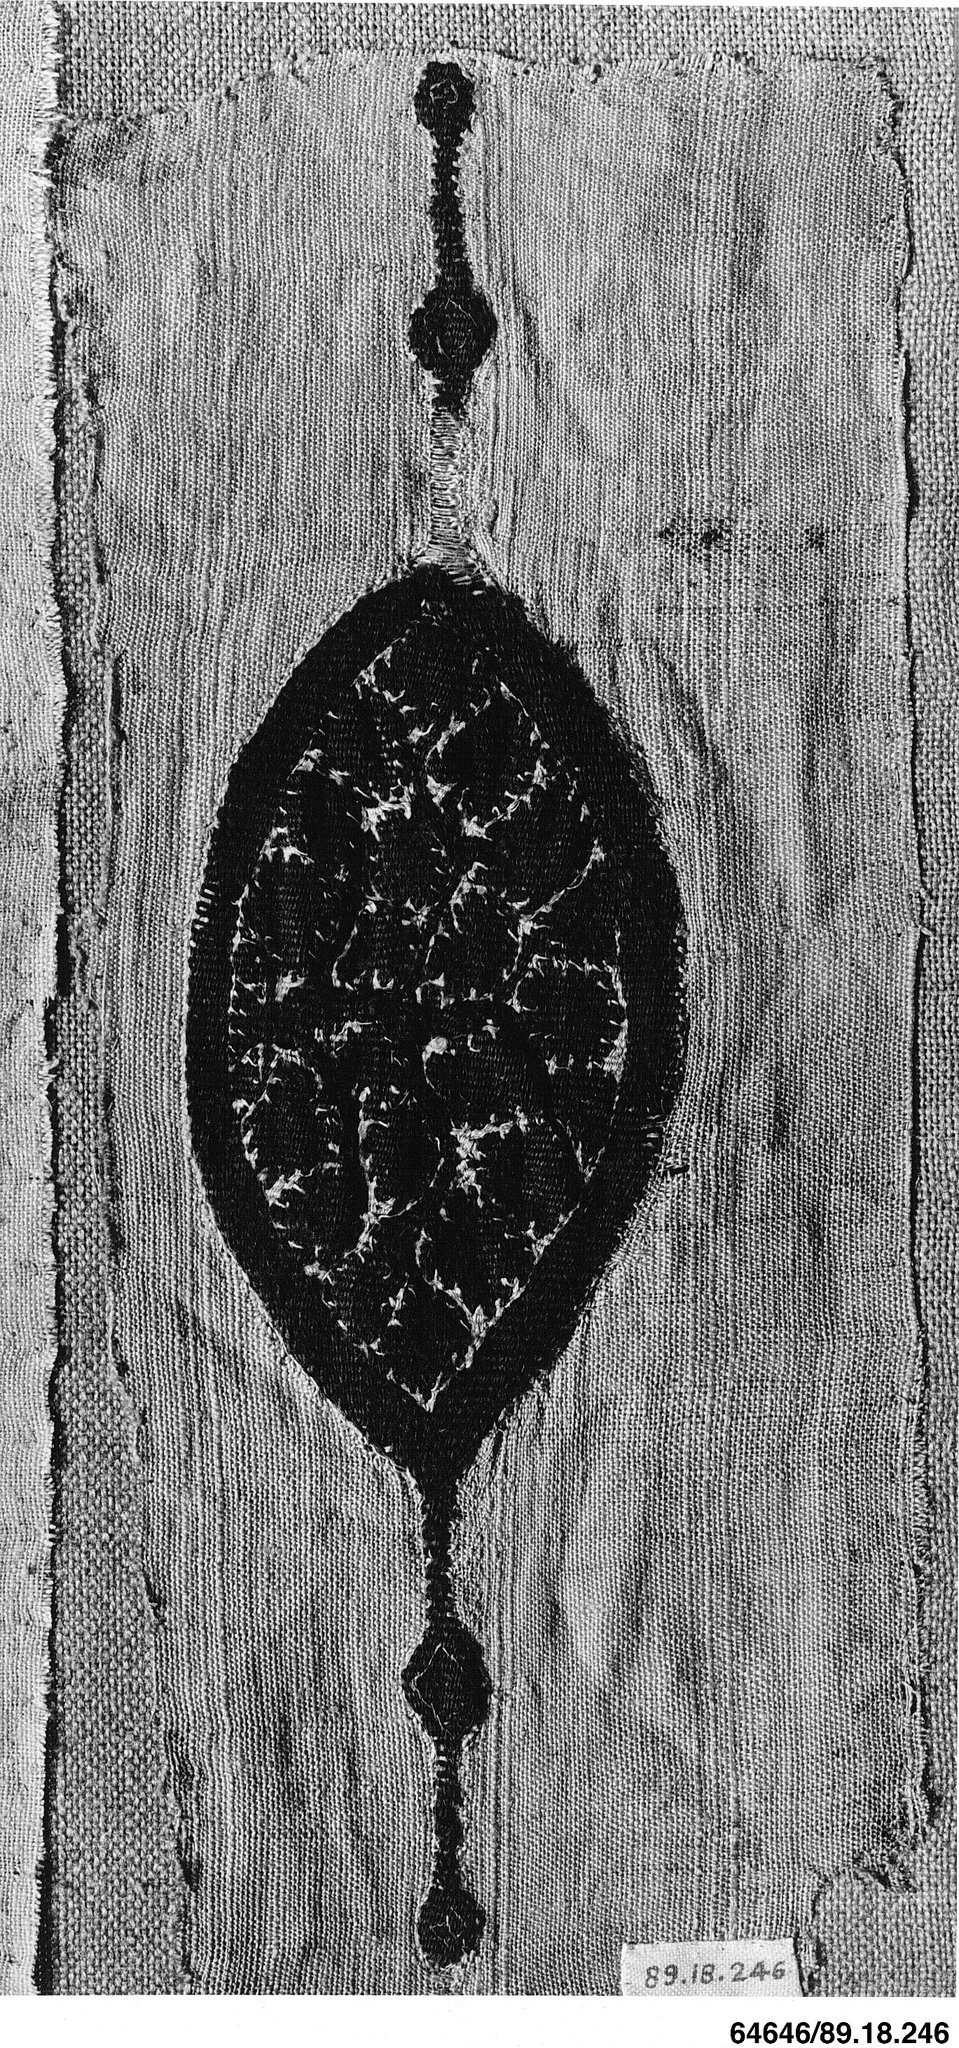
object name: textile fragment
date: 201-400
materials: linen, wool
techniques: weave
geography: egypt